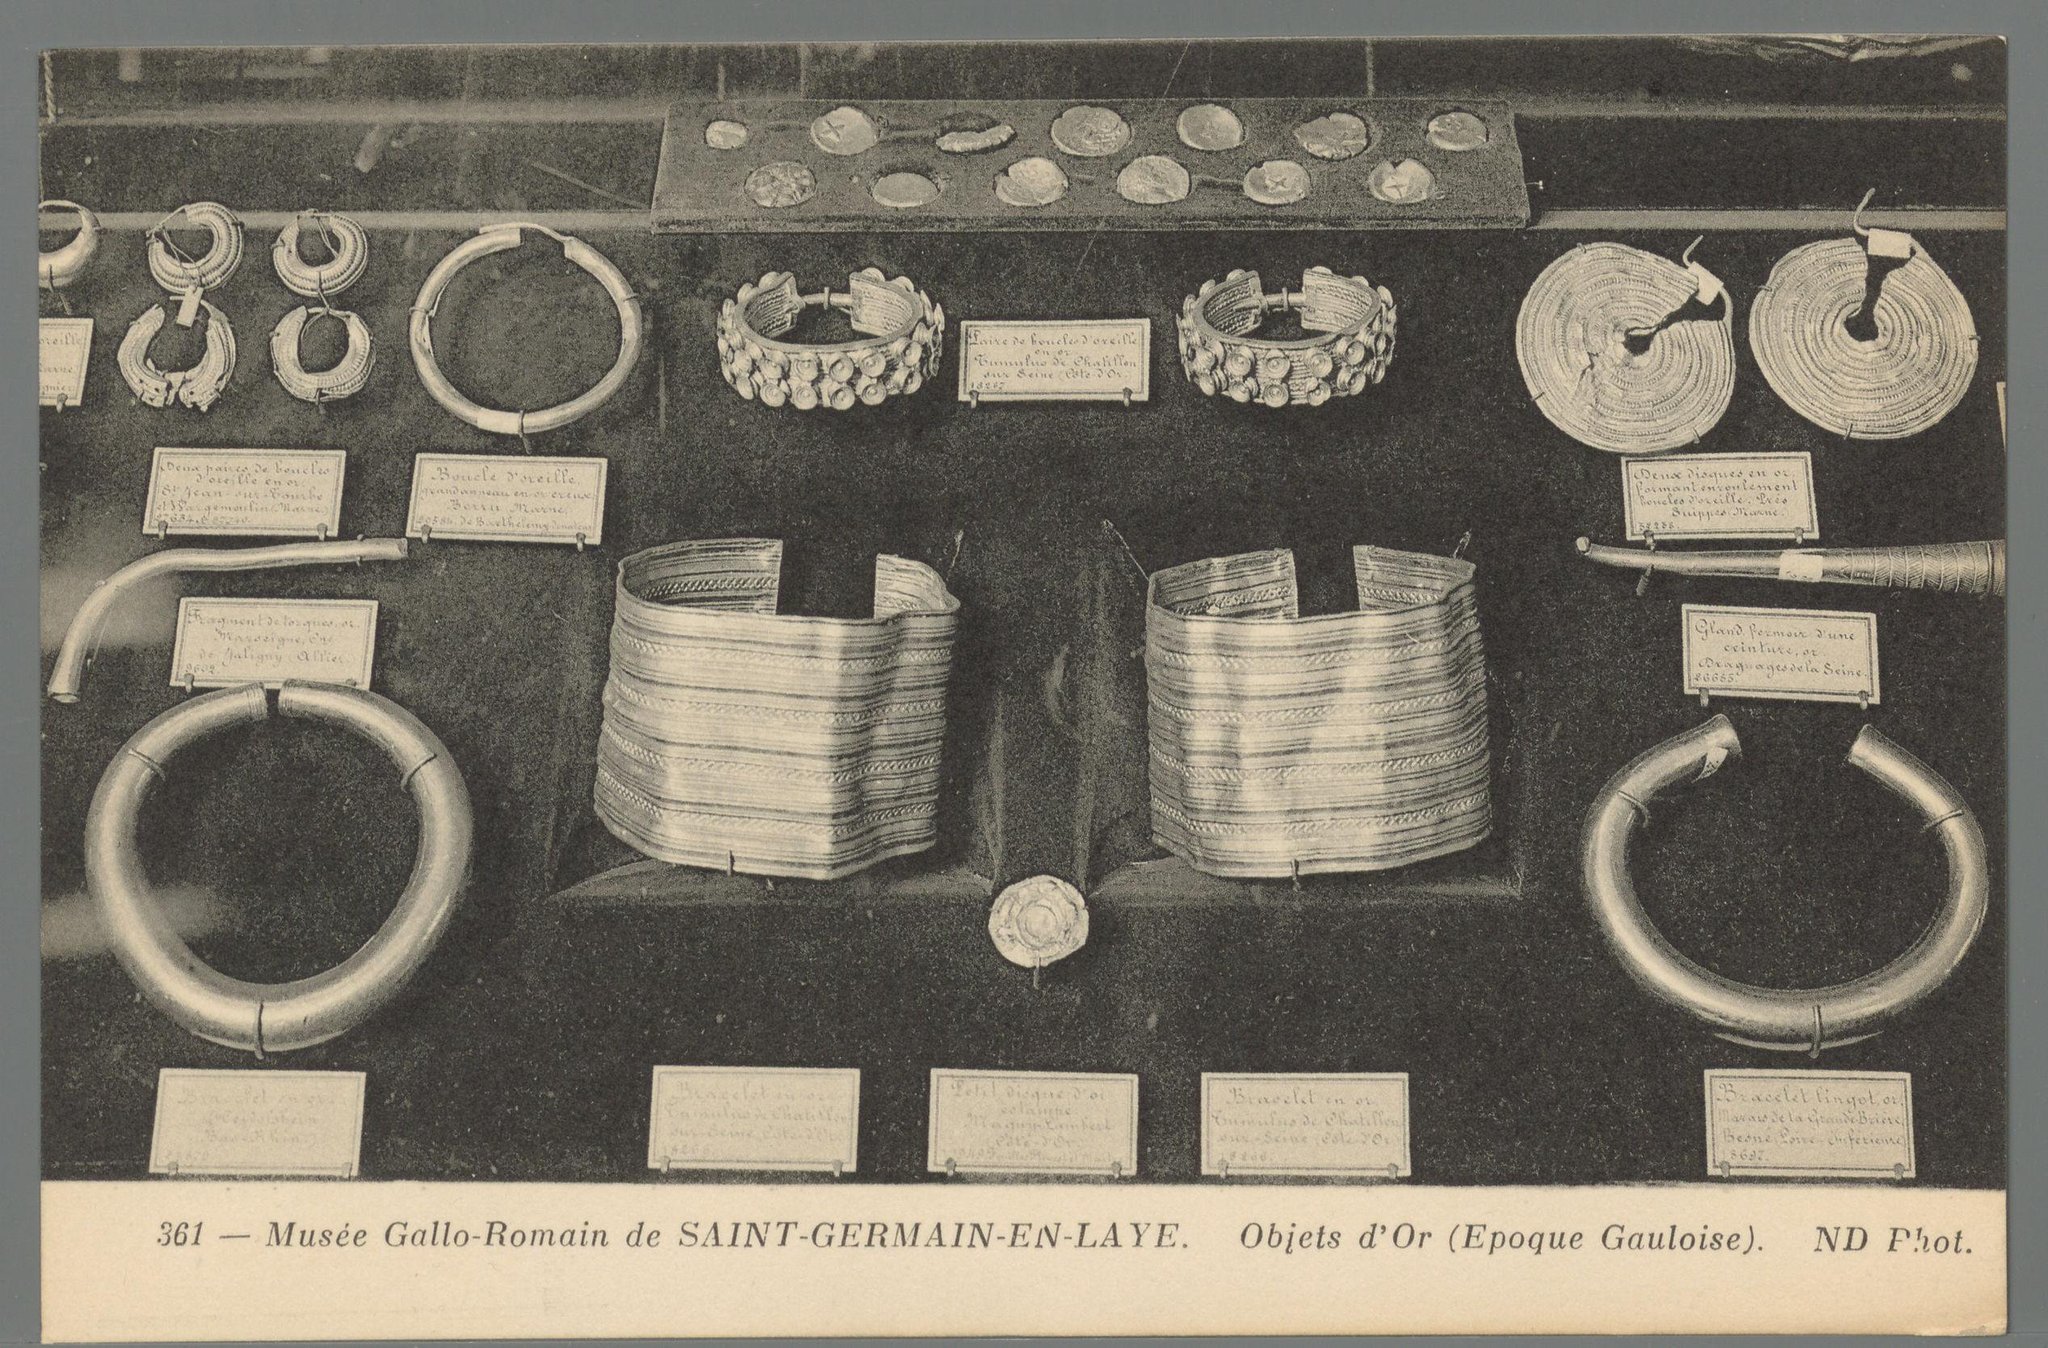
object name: ansichtkaart, prentbriefkaart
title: Musée Gallo-Romain de Saint-Germain-en-Laye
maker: Anonymous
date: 1903-1918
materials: cardboard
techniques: photograph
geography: saint-germain-en-laye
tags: ornaments, jewels, permanent exhibition, museum, minerals and metals: gold